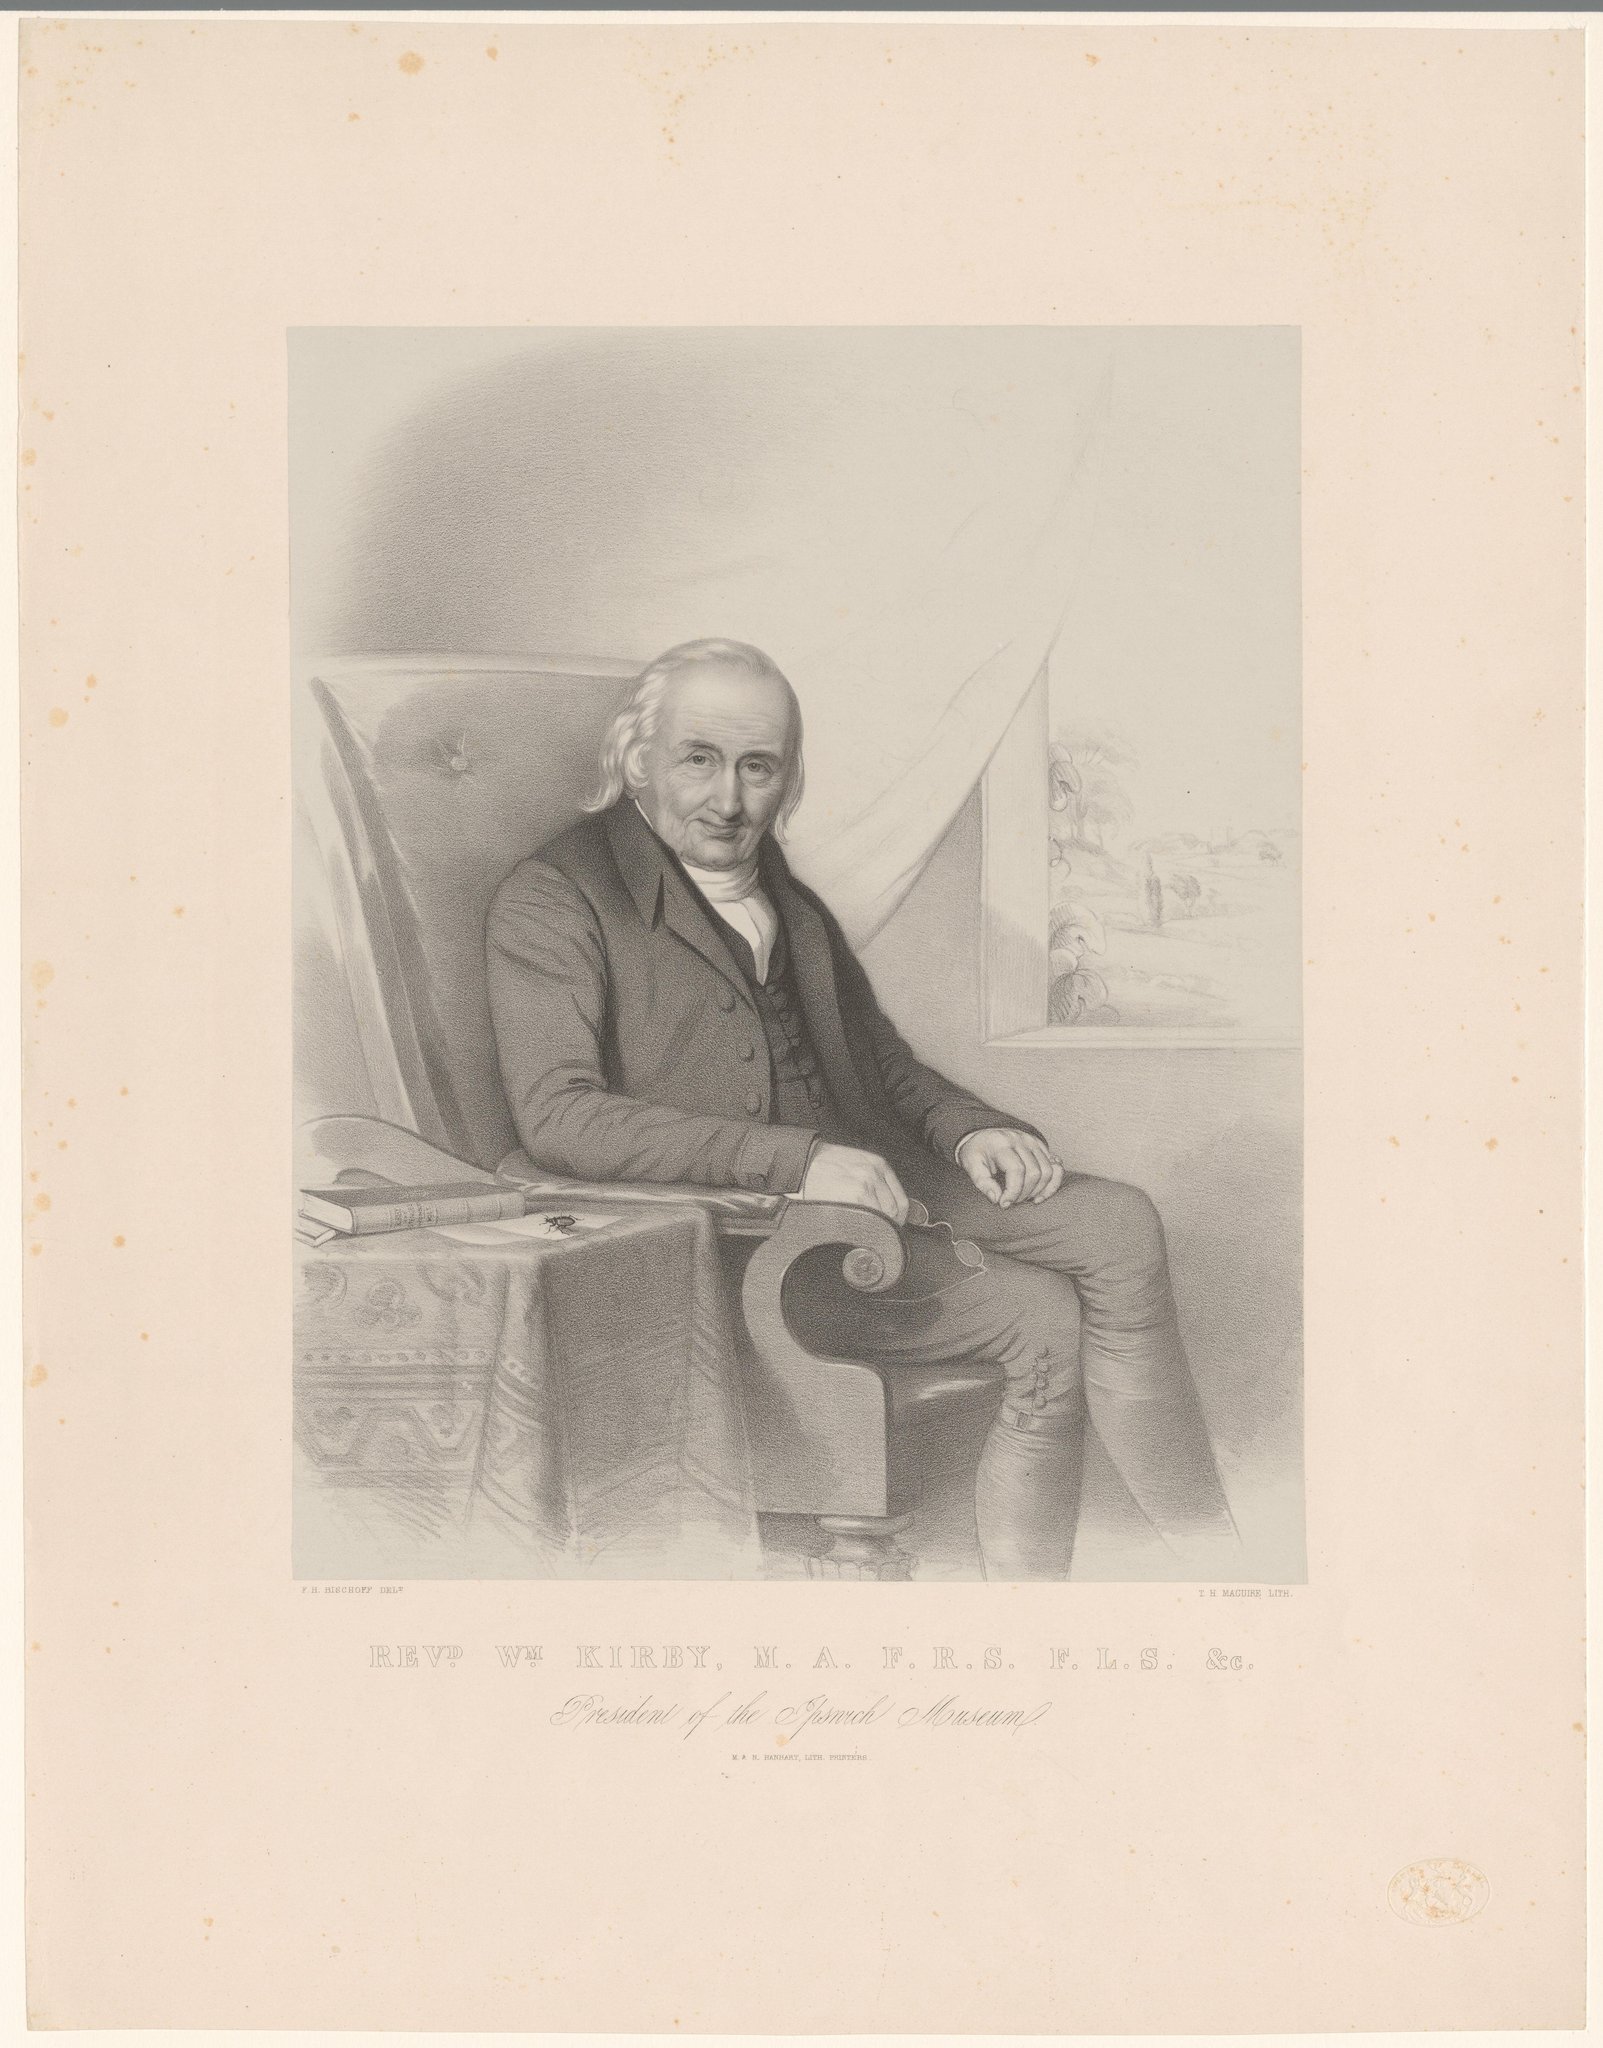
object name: print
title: Revd. Wm. Kirby (...) President of the Ipswich Museum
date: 1852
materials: paper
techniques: lithograph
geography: london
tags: eyeglasses, spectacles, adult man, historical persons, insects: beetle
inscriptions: collector's mark: Lugt 2228, check stamp: ‘Ipswich Museum’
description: Prent behoort tot de serie 'Ipswich Museum Portraits', ook bekend onder de titel 'Portraits of Honorary Members of the Ipswich Museum'. Deze serie is in 1852 door George Ransome uitgegeven en gedrukt door M&N Hanhart tussen 1848 en 1852. De serie bestaat uit ca. 60 portretten.